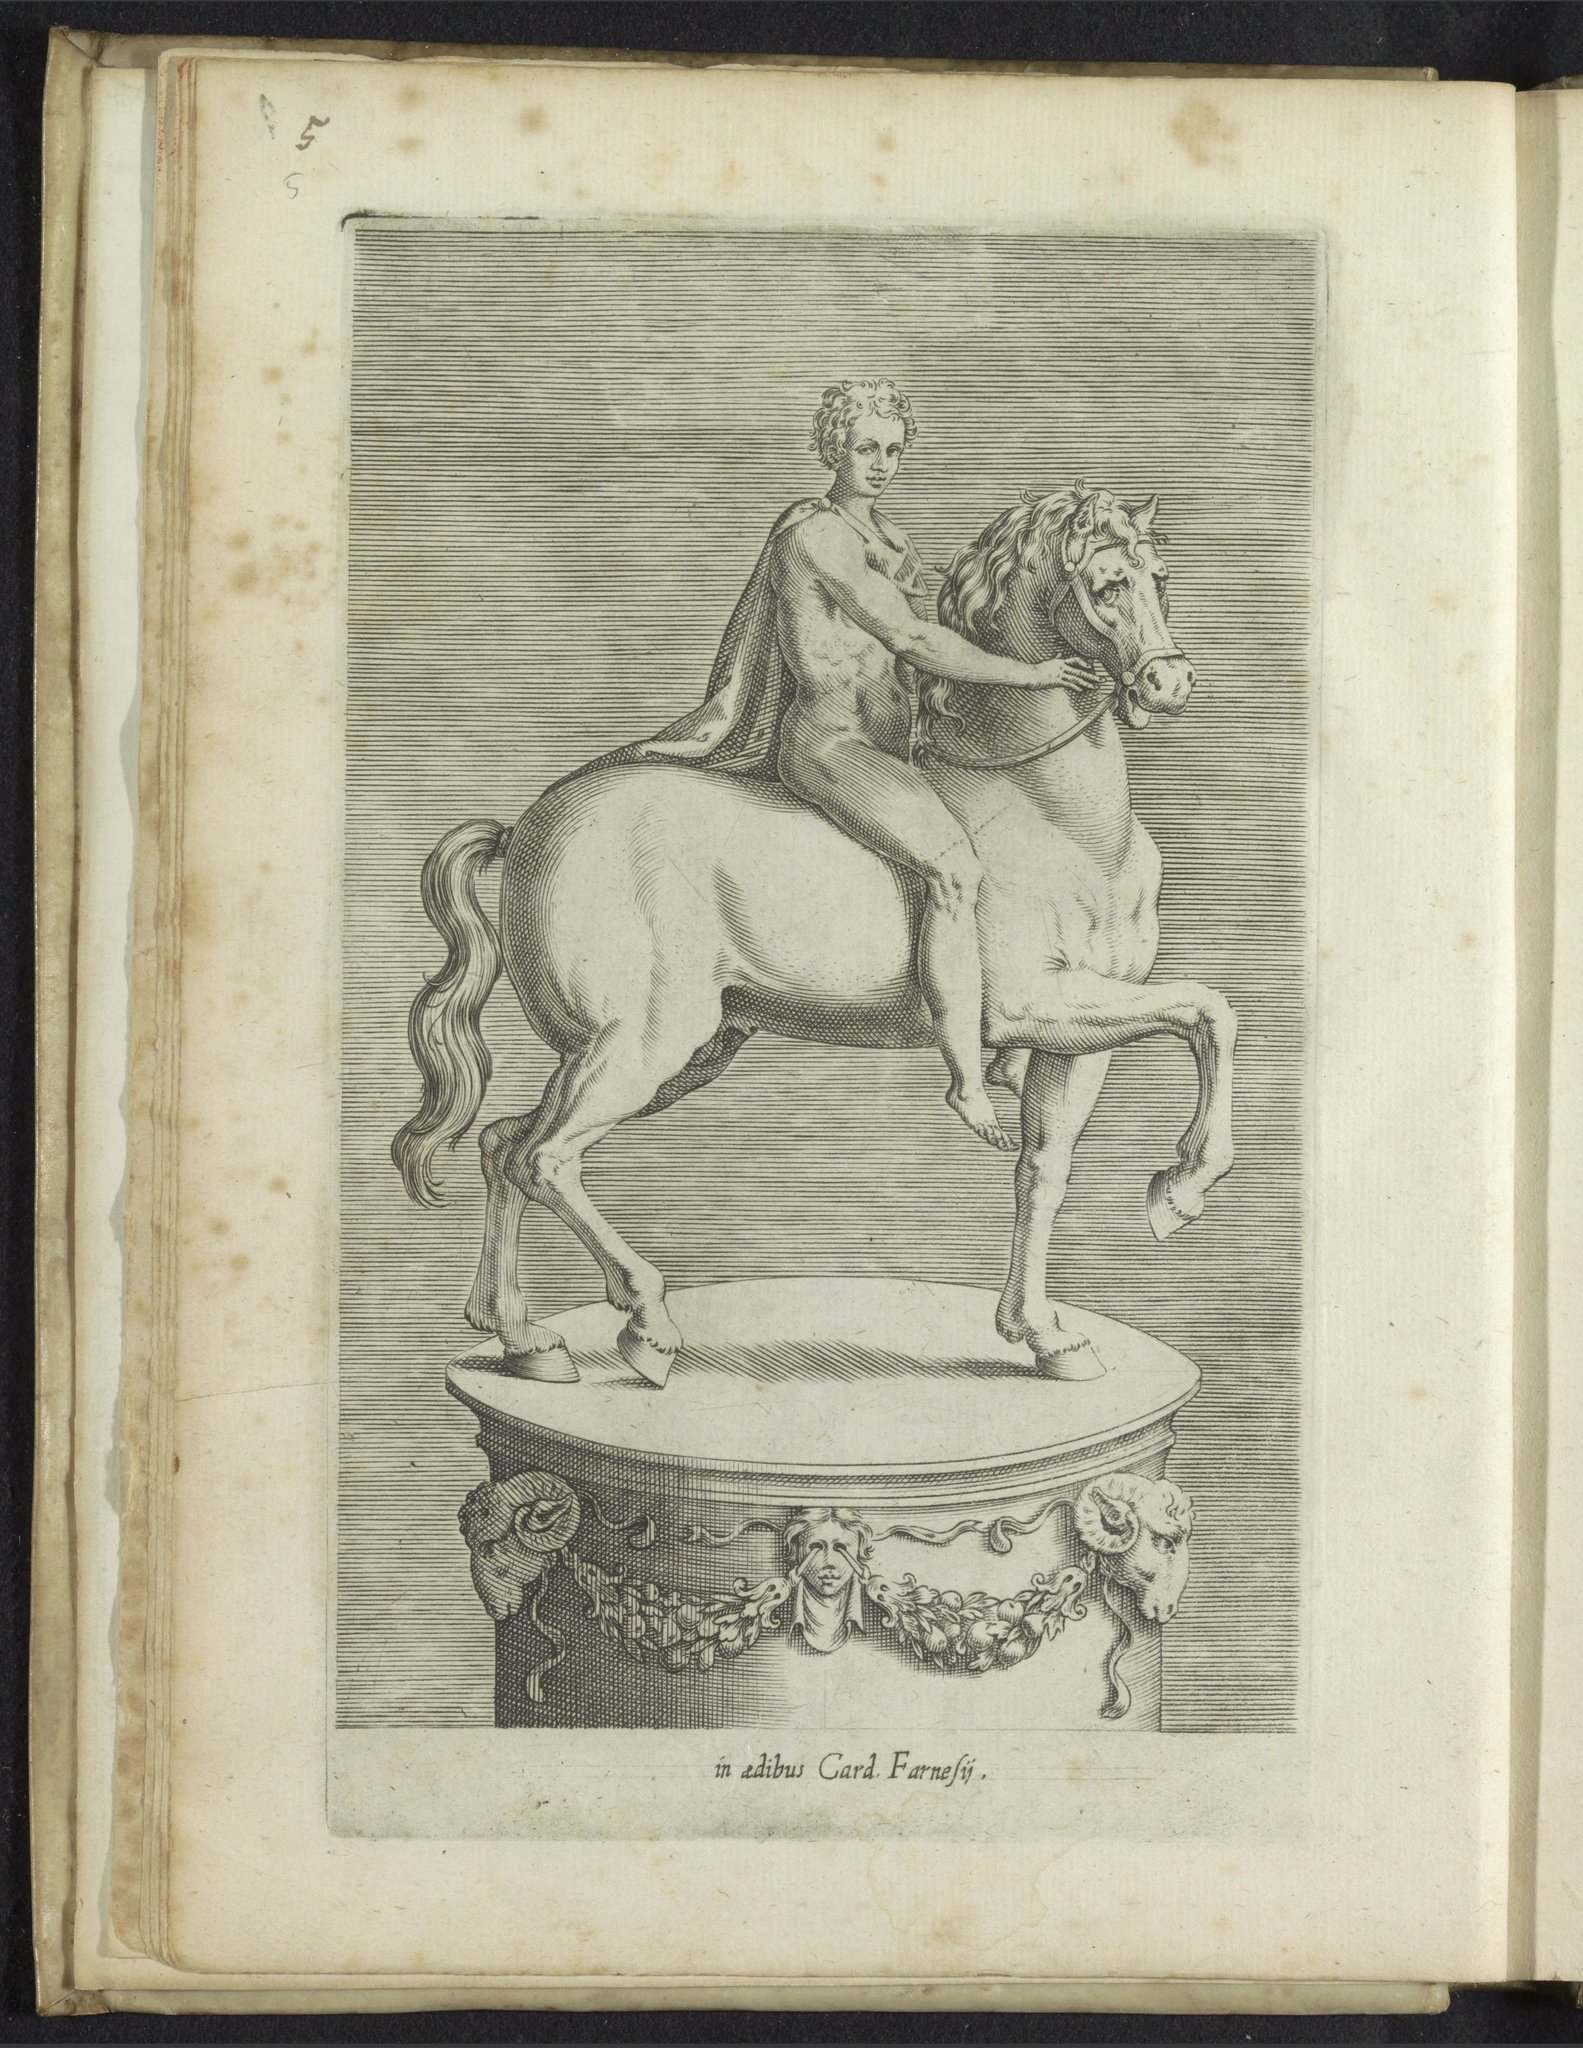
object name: album leaf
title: Antieke sculpturen in Rome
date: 1584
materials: paper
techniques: engraving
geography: italy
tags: equestrian state-portrait, piece of sculpture, reproduction of a piece of sculpture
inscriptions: number: ‘5’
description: Naar een beeld dat in de zestiende eeuw werd gevonden nabij Rome. Vanaf 1652 stond het beeld in Palazzo Farnese. Vandaag de dag staat het in het British Museum te Londen. Deze prent maakt deel uit van een set van 79 prenten (+ titelprent) met voorstellingen van antieke sculpturen in Rome.